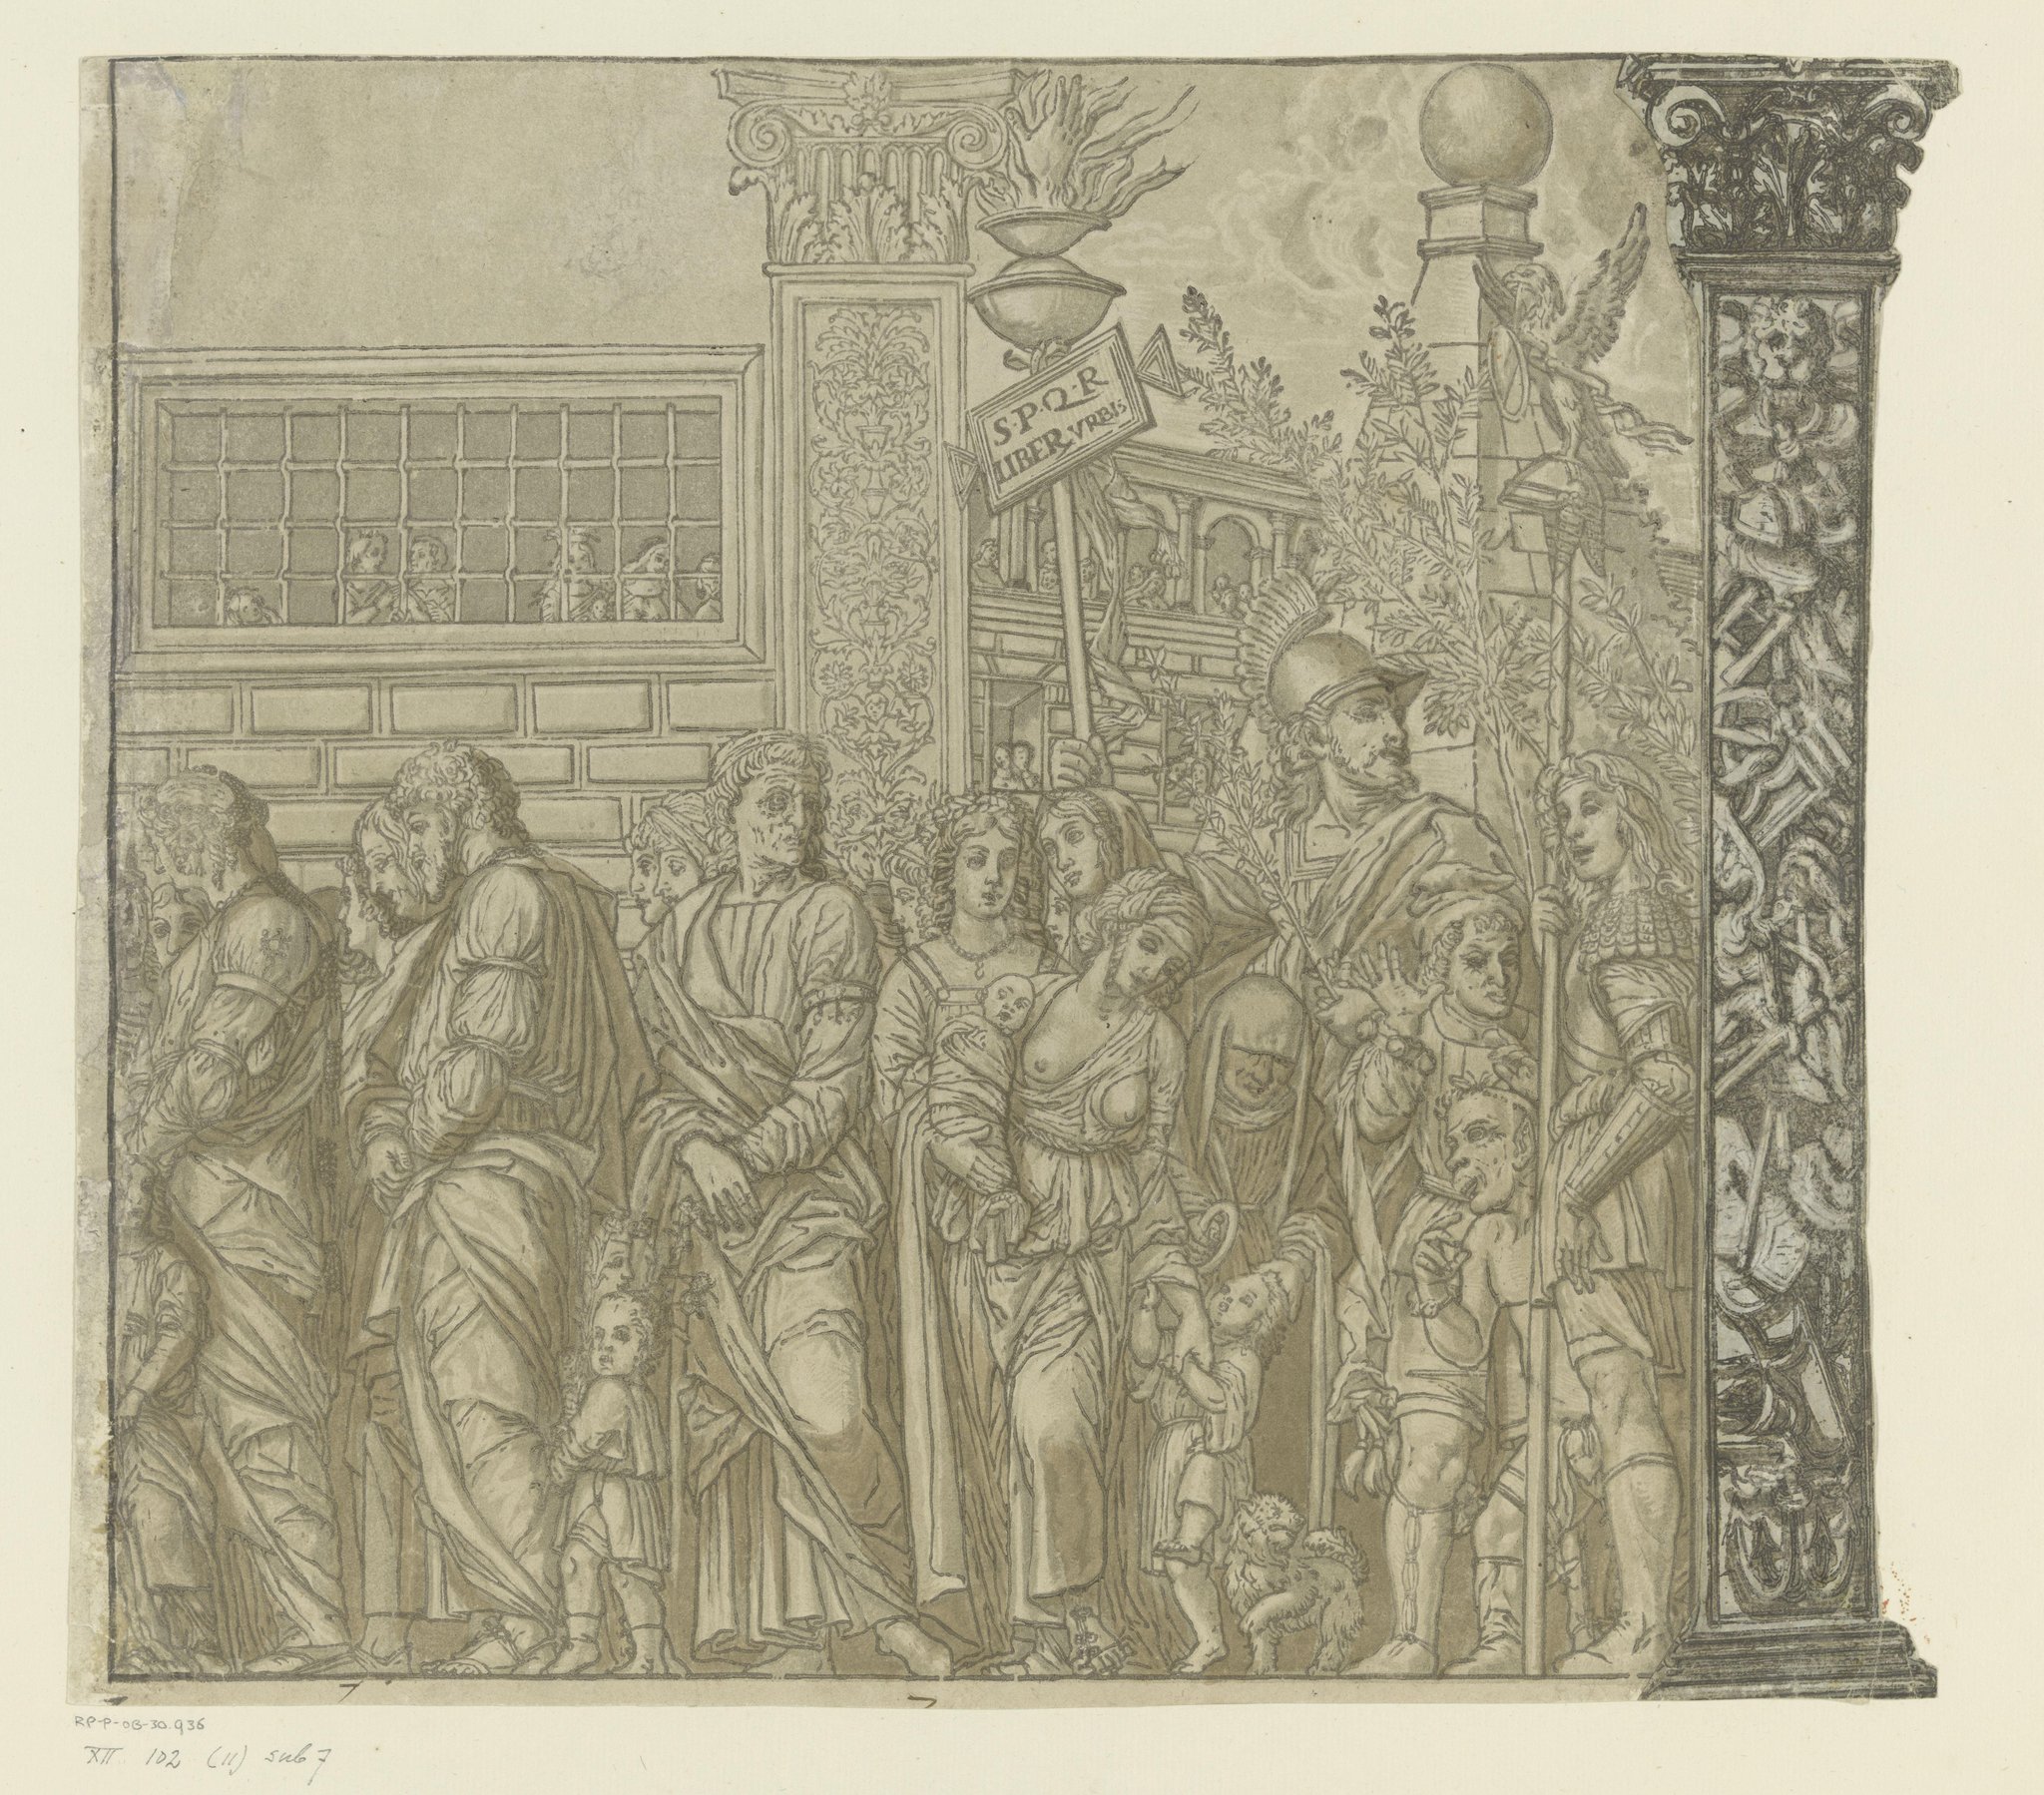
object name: print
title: Triomftocht van Julius Caesar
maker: andrea andreani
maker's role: print maker, printer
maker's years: 1558-1629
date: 1599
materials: paper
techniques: woodcut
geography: mantua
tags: torch, triumph of caesar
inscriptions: collector's mark: Lugt 240, number: ‘7’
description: Deze prent maakt deel uit van een fries dat bestaat uit een titelprent en negen prenten die samen een triomftocht van Julius Caesar vormen. Bij de serie hoort tevens een prent met daarop zes Korinthische pilasters, bedoeld om te worden uitgeknipt en gebruikt als verbindingsstukken tussen de verschillende bladen. Op dit exemplaar is een pilaster aan de rechterkant gemonteerd. Op de achterzijde van de pilaster een afdruk van een andere clair-obscur houtsnede.